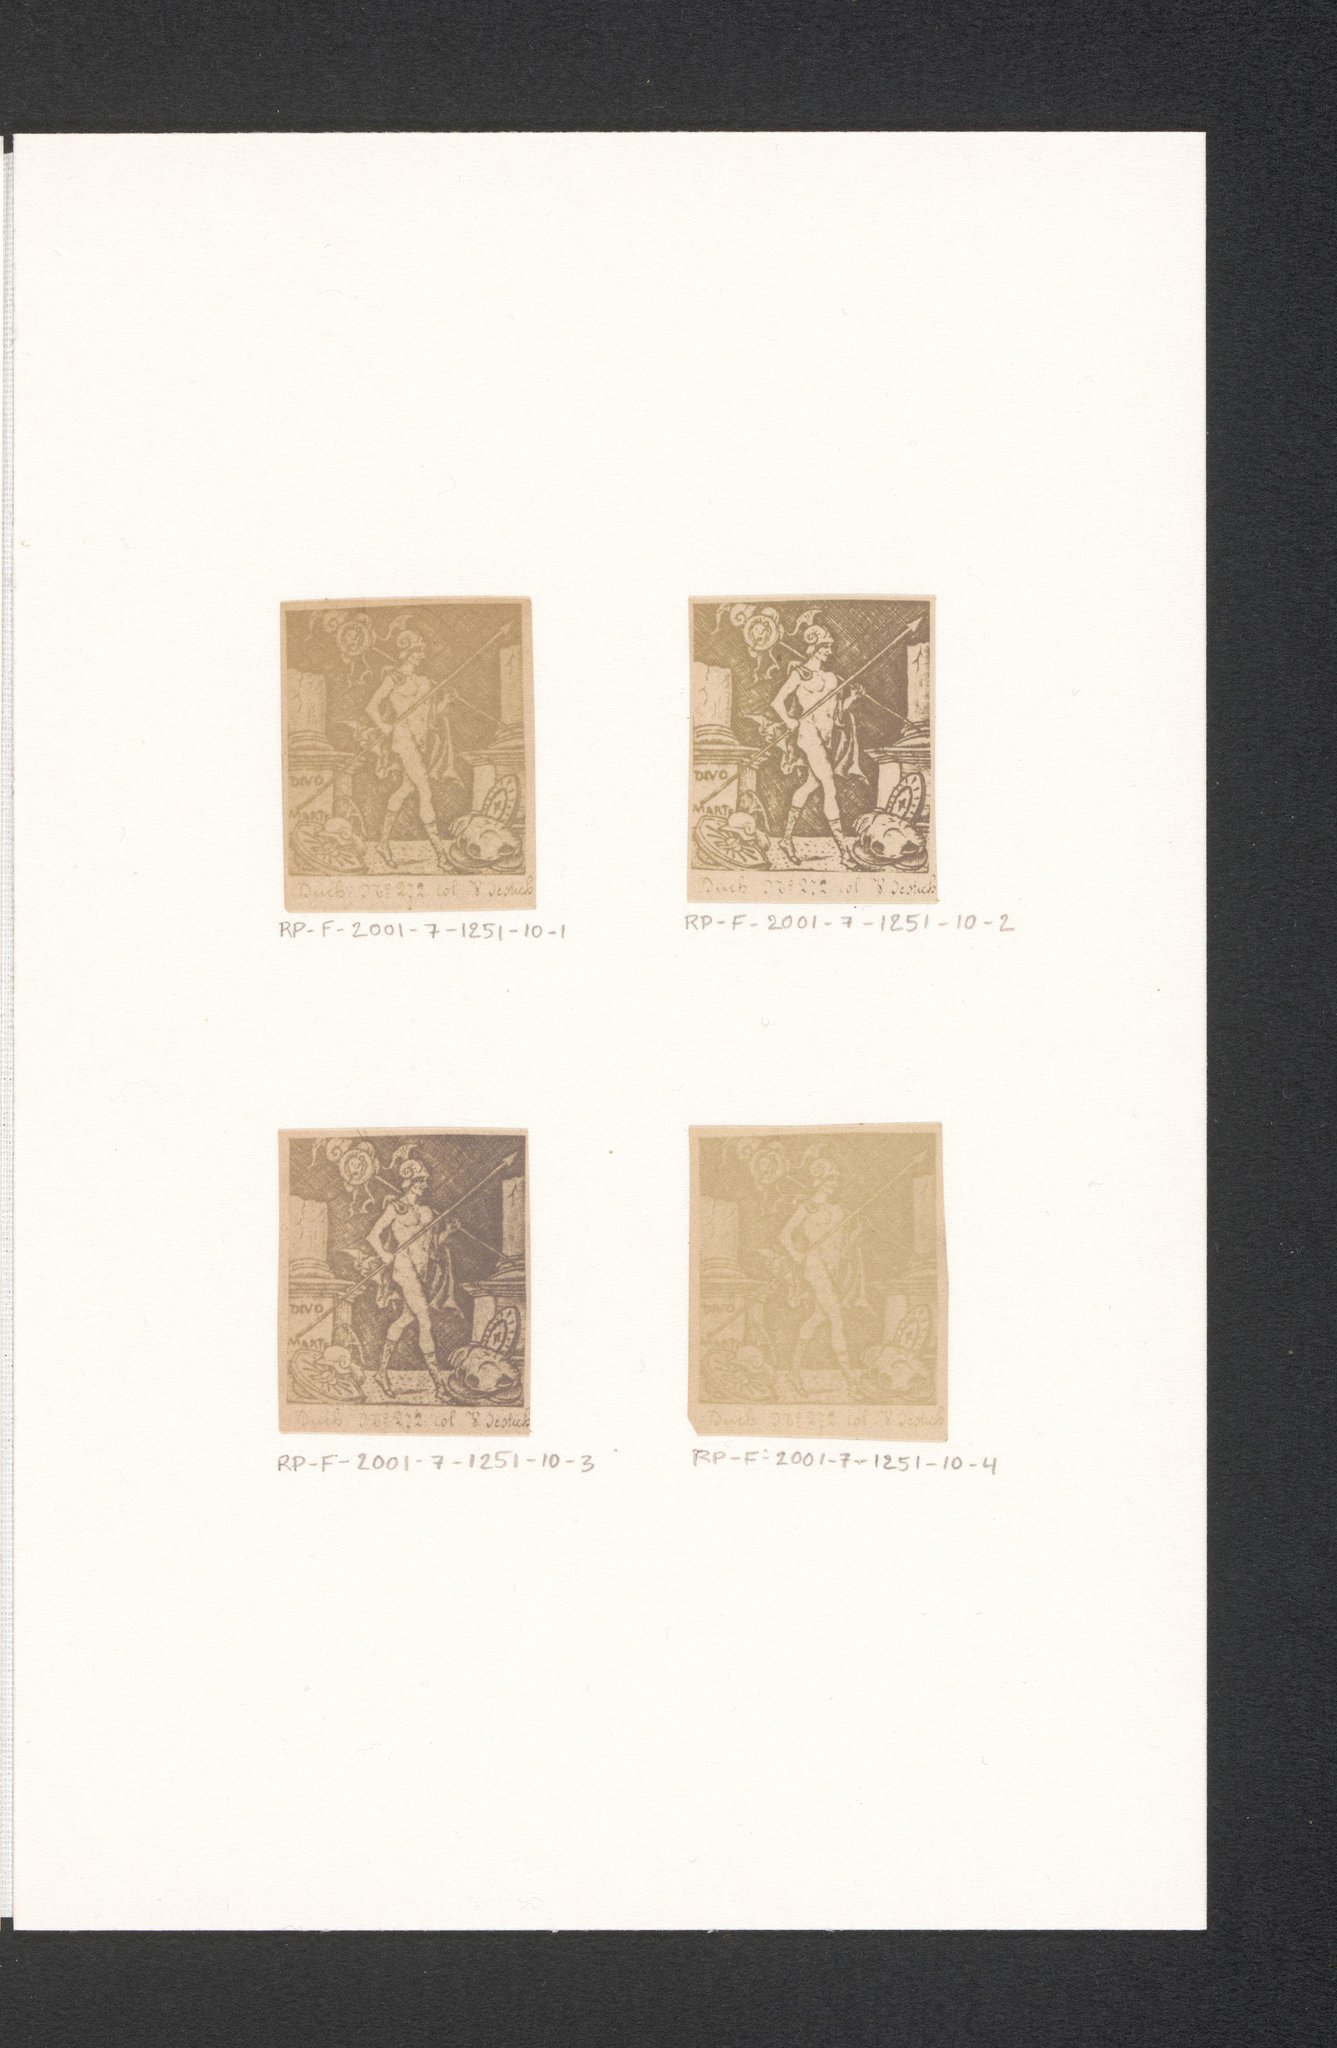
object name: reproduction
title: Fotoreproductie van een prent van een krijger met een trofee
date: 1852-1857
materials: photographic support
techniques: salted paper print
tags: adult man, trophy ~ battle, war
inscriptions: inscription: ‘Duch. [N]o. 272 col. V. Sestich’